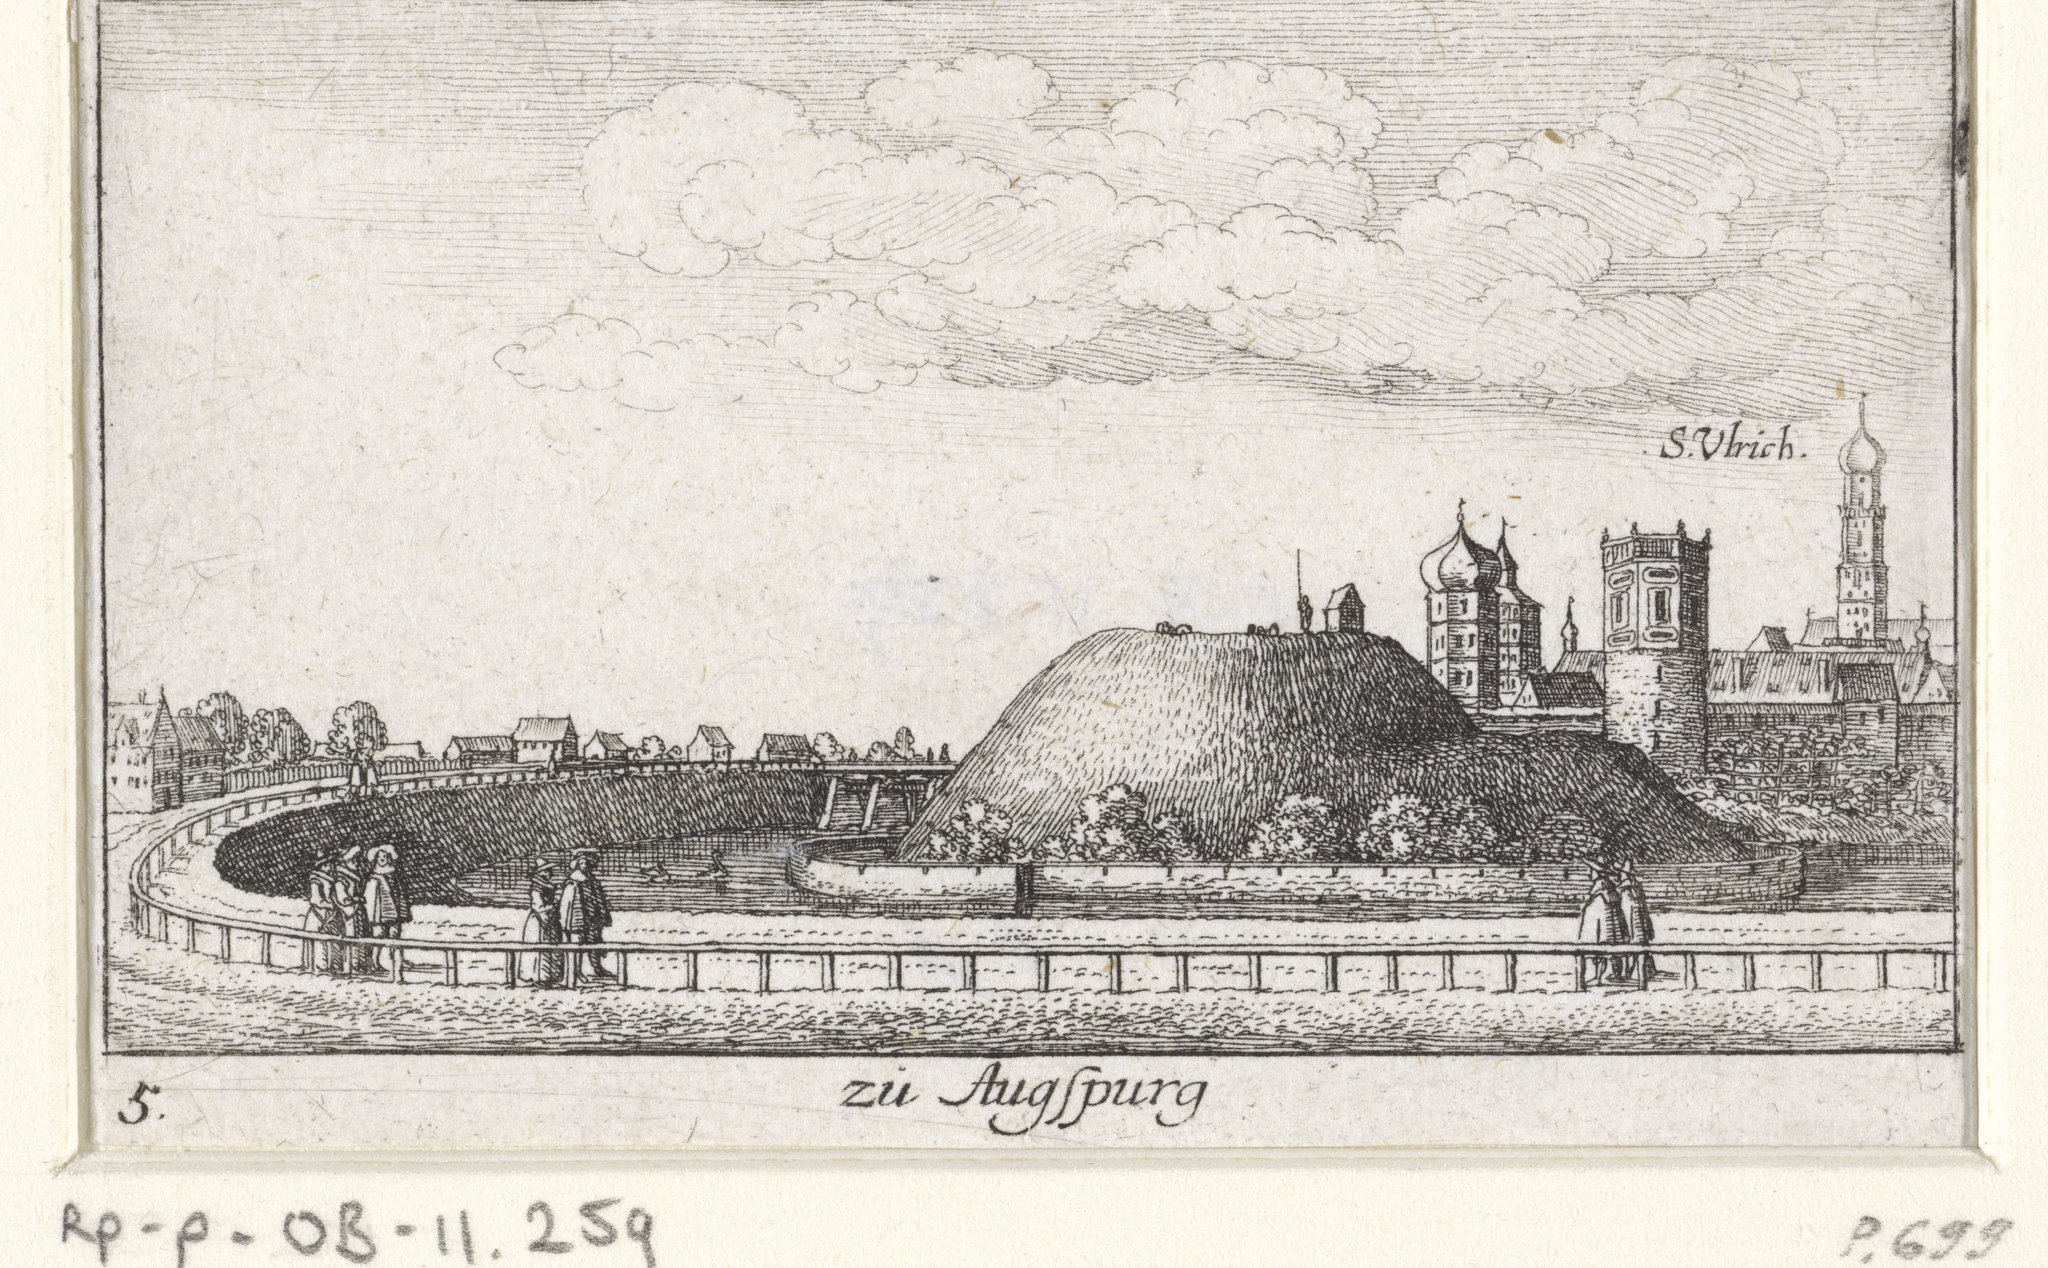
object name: print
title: Gezicht te Augsburg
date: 1635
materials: paper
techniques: etching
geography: cologne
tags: city-view, and landscape with man-made constructions, augsburg